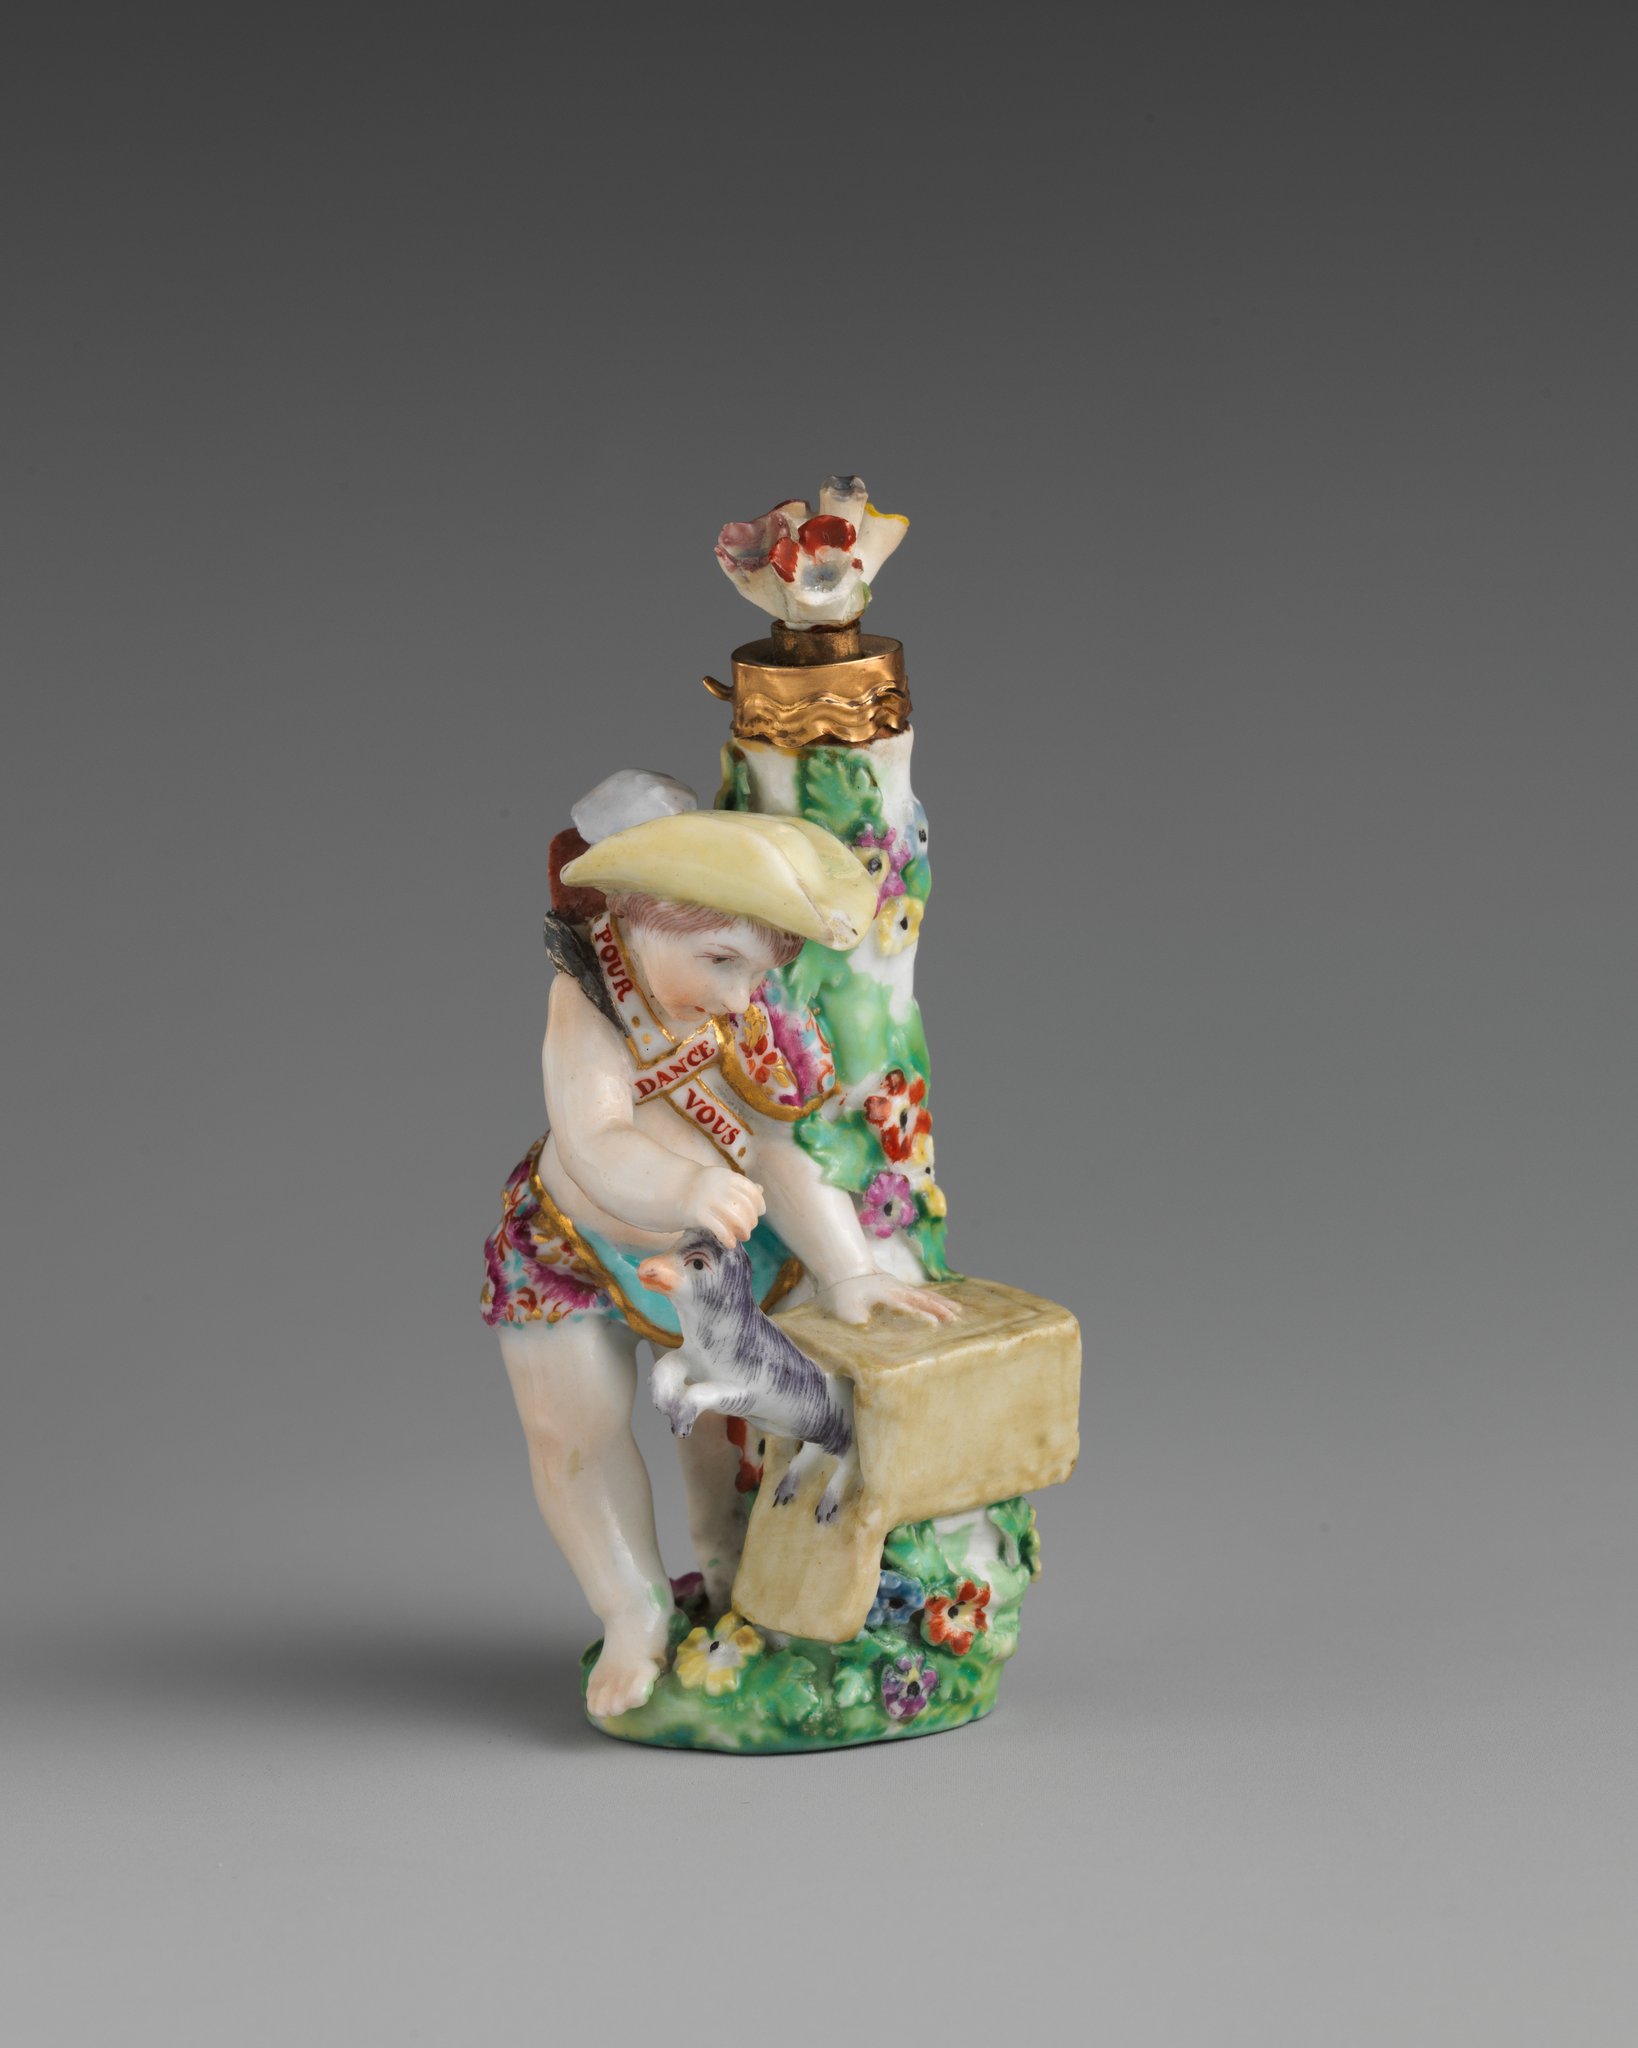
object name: toy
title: Cupid with dog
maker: chelsea porcelain manufactory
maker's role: factory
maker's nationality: british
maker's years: 1744-1784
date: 1765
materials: soft paste porcelain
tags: cupid,dogs,flowers